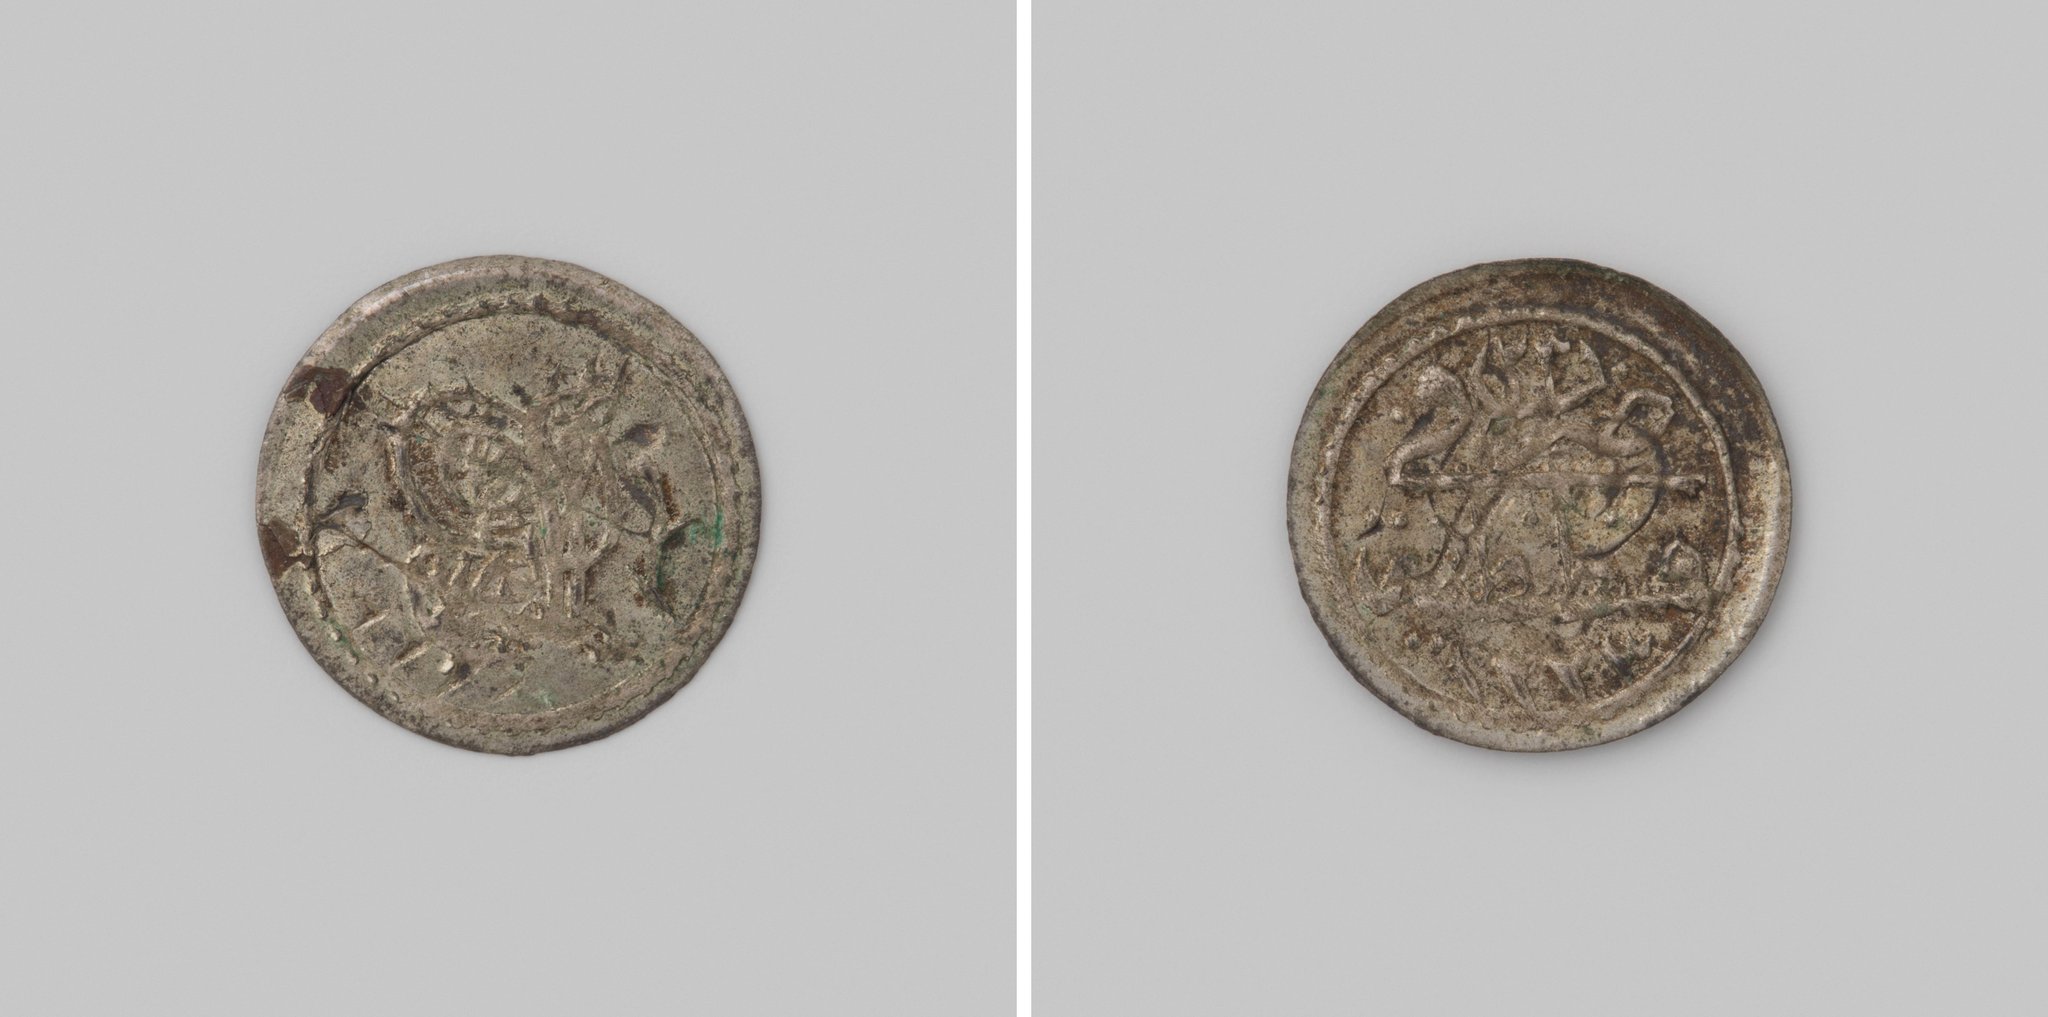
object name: coin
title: Para uit Turkije van sultan Mahmud II, regeringsjaar 23 [=1830]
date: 1830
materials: silver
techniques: striking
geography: constantinople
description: Zilveren munt. Voorzijde: tughra, met rechts daarvan takje. Keerzijde: vierregelig opschrift in Arabische letters met muntplaats-aanduiding: Constantinopel. Boven in opschrift regeringsjaar: 23. Onderaan jaar van aantreden: 1223 [=1808].